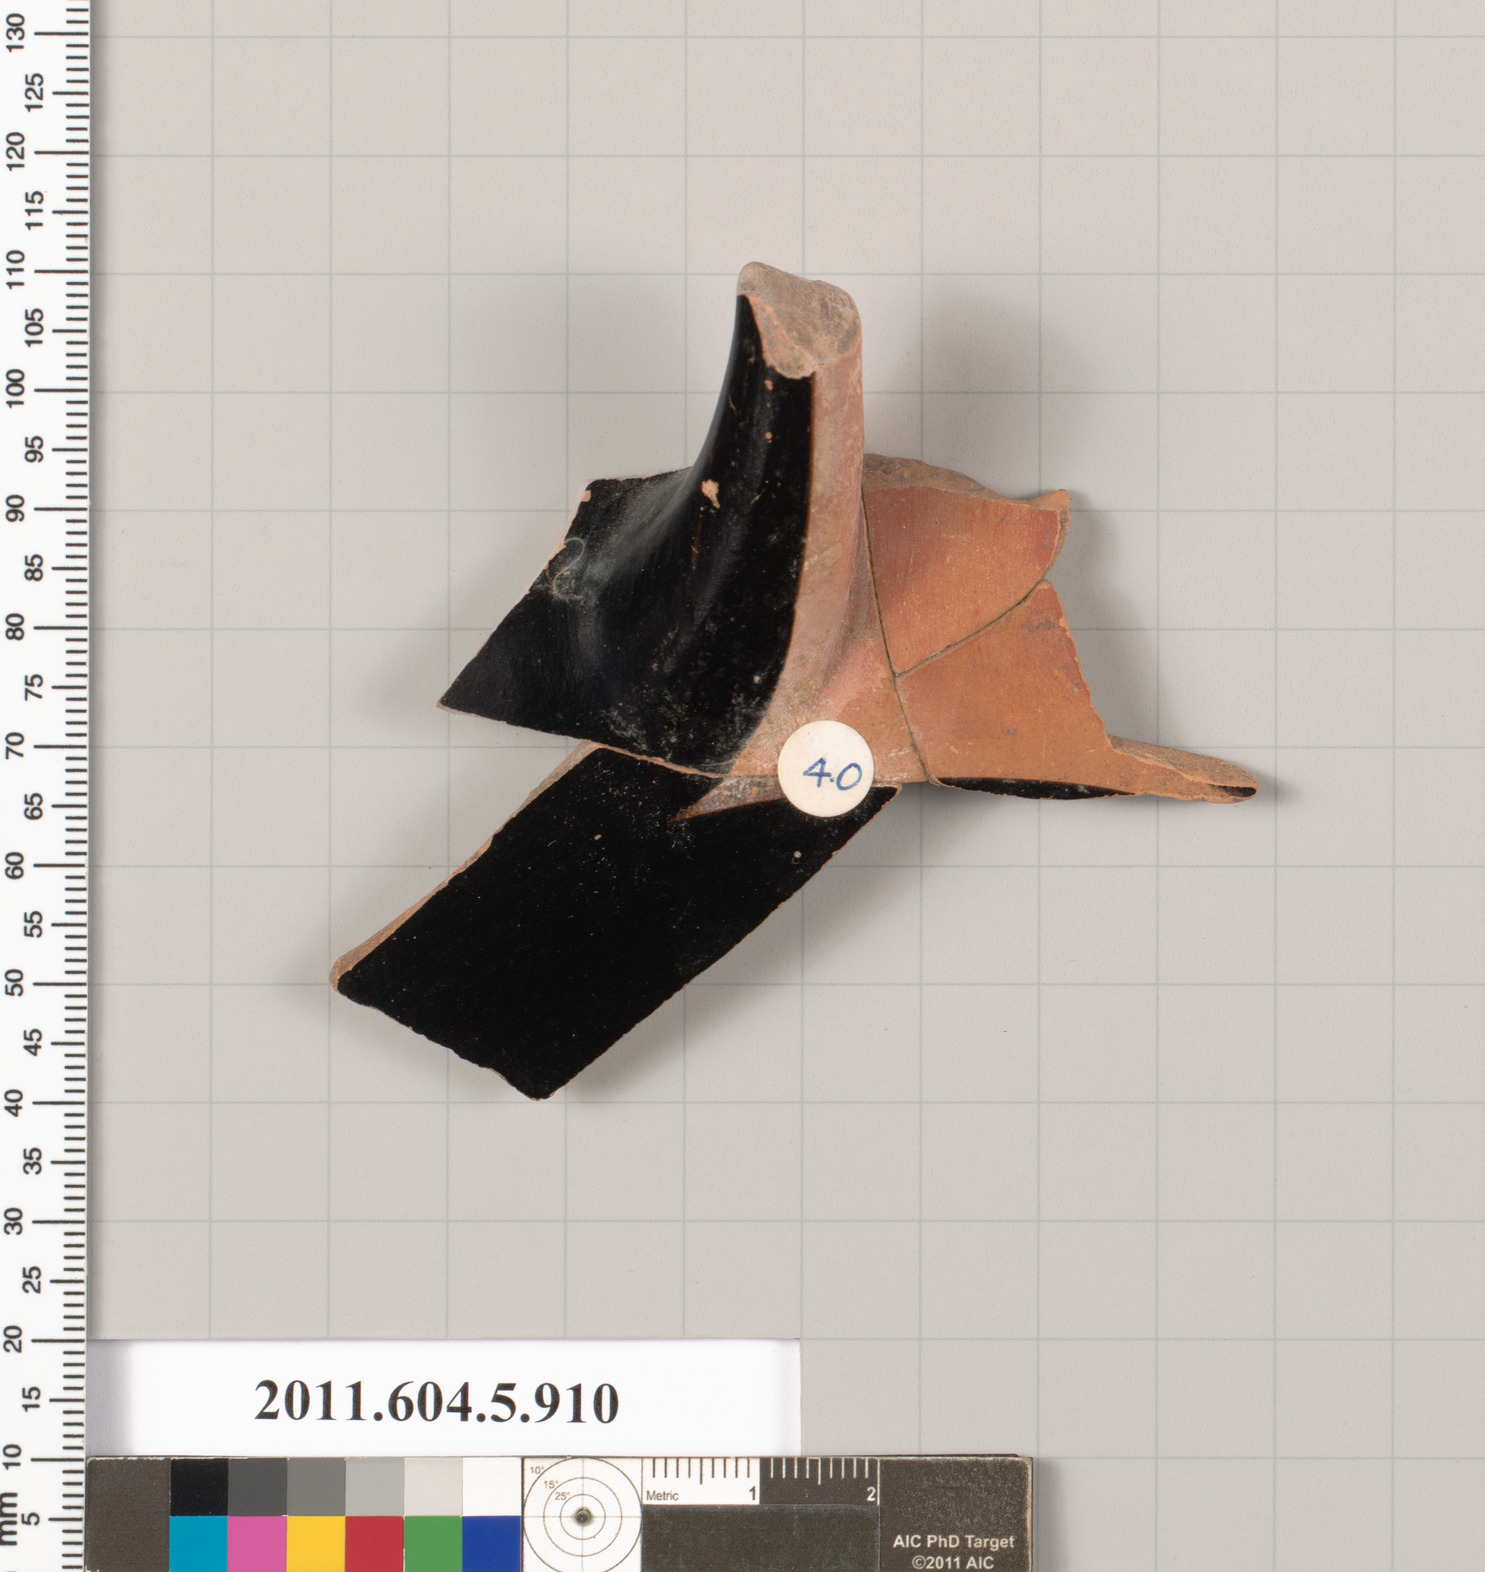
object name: kylix fragment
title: Terracotta fragment of a kylix (drinking cup)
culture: greek, attic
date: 600-401 BCE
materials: terracotta